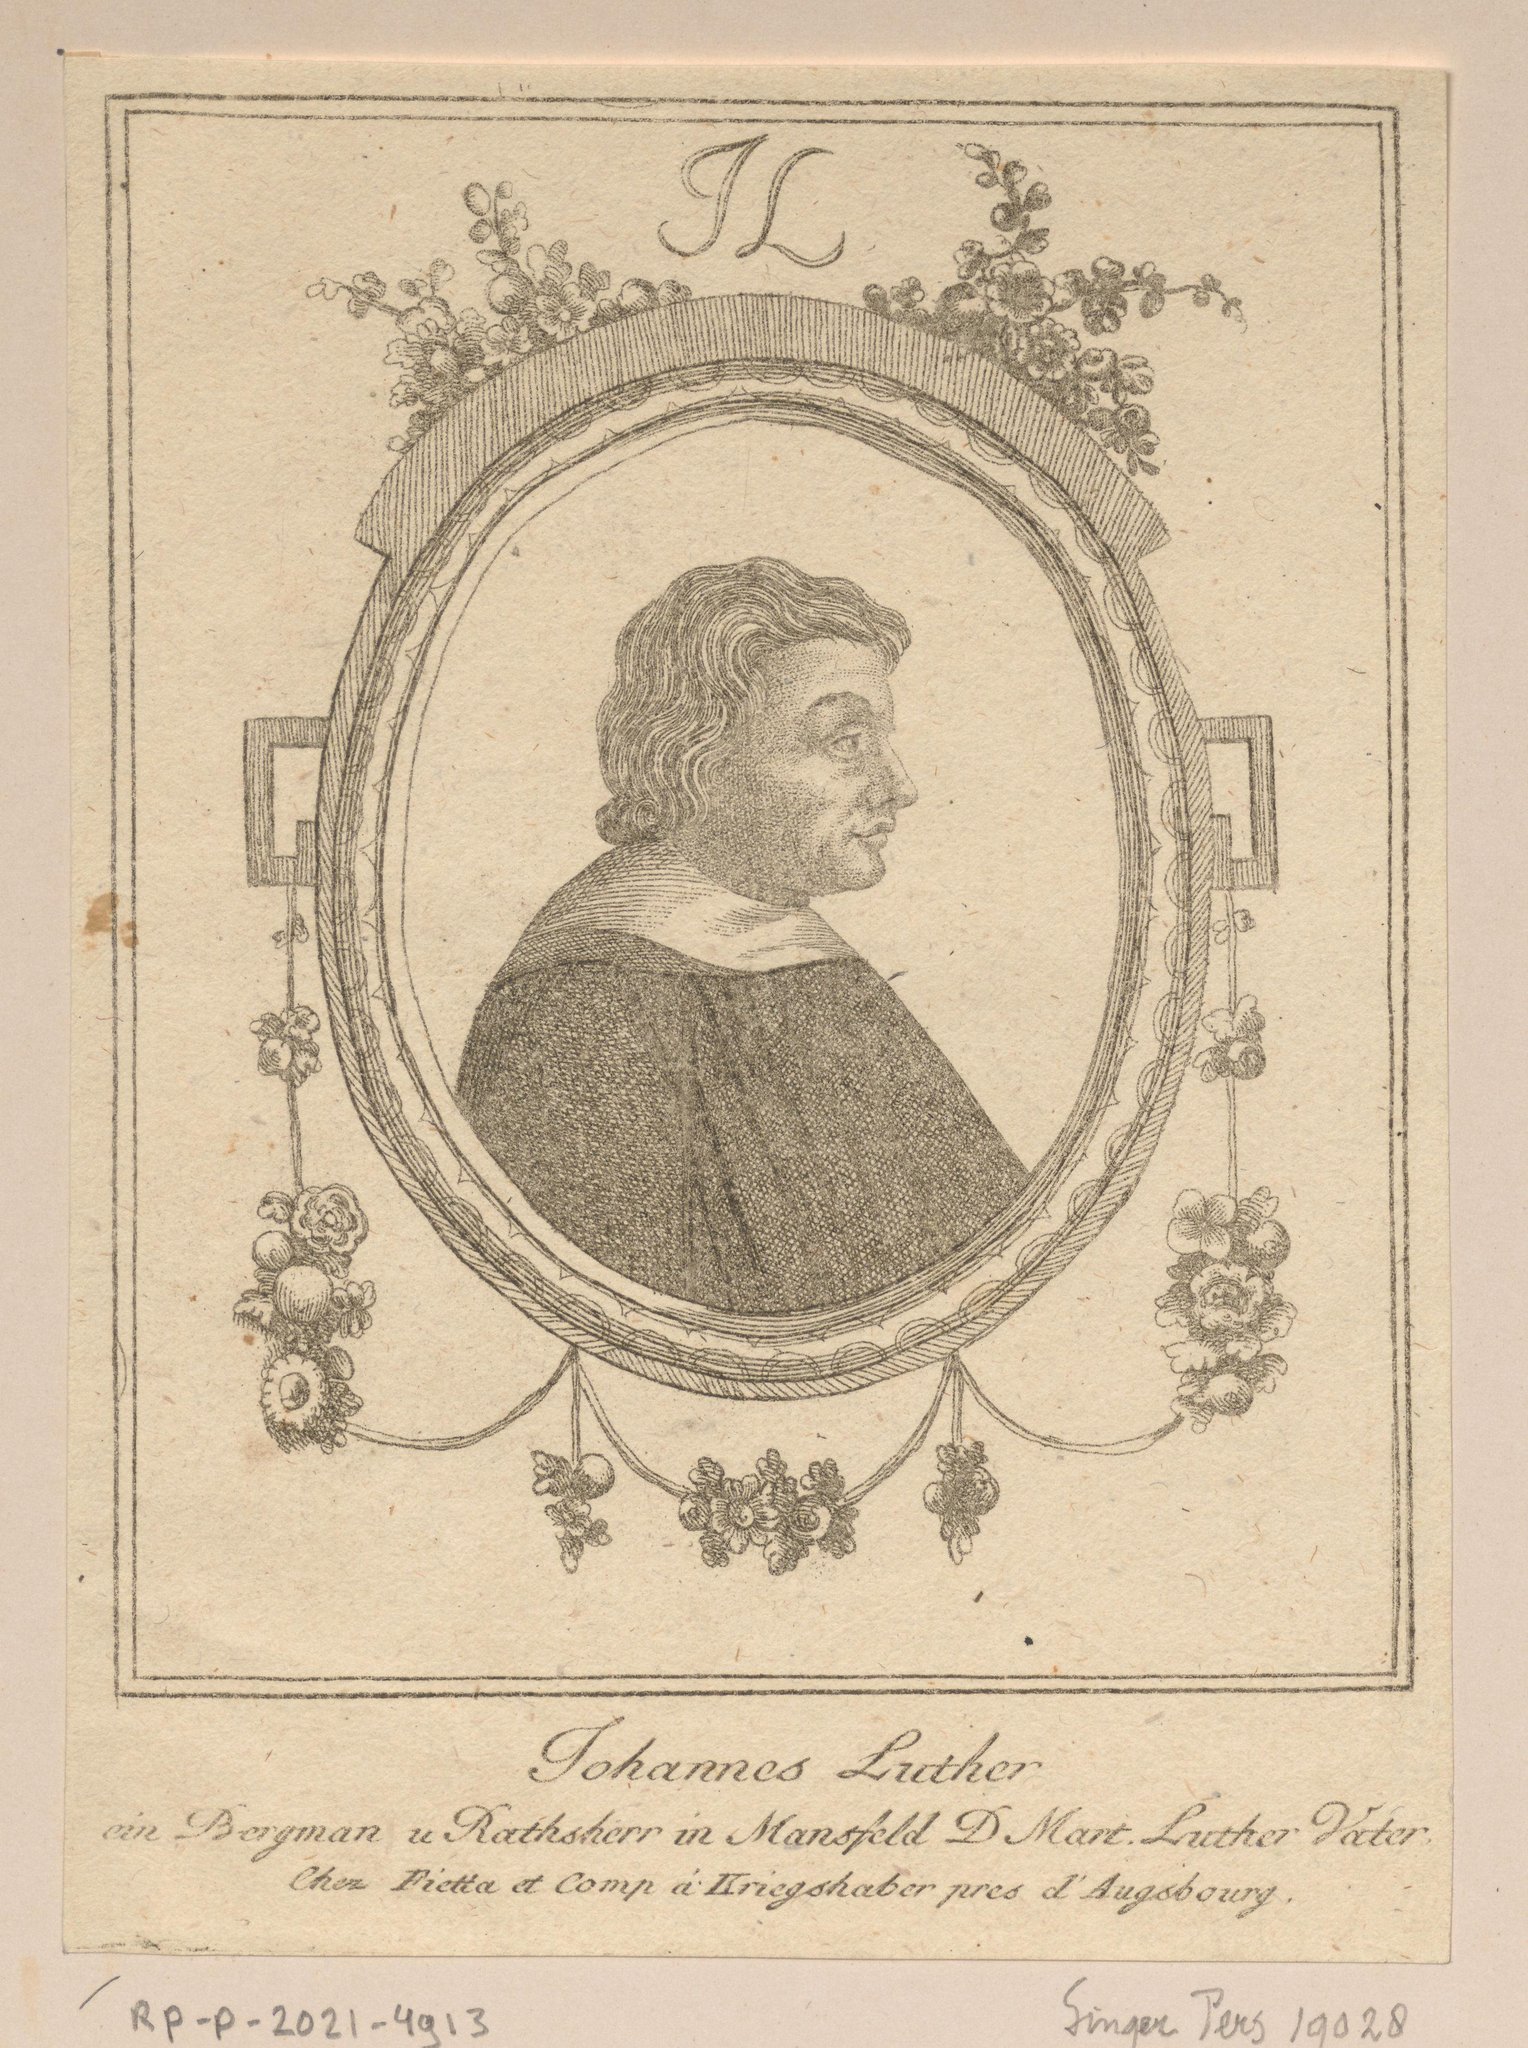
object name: print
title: Portret van Martin Luther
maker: Anonymous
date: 1700-1799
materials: paper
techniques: etching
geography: germany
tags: priest, martin luther, theologian, historical persons